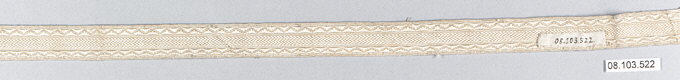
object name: galloon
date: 1701-1900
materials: silk